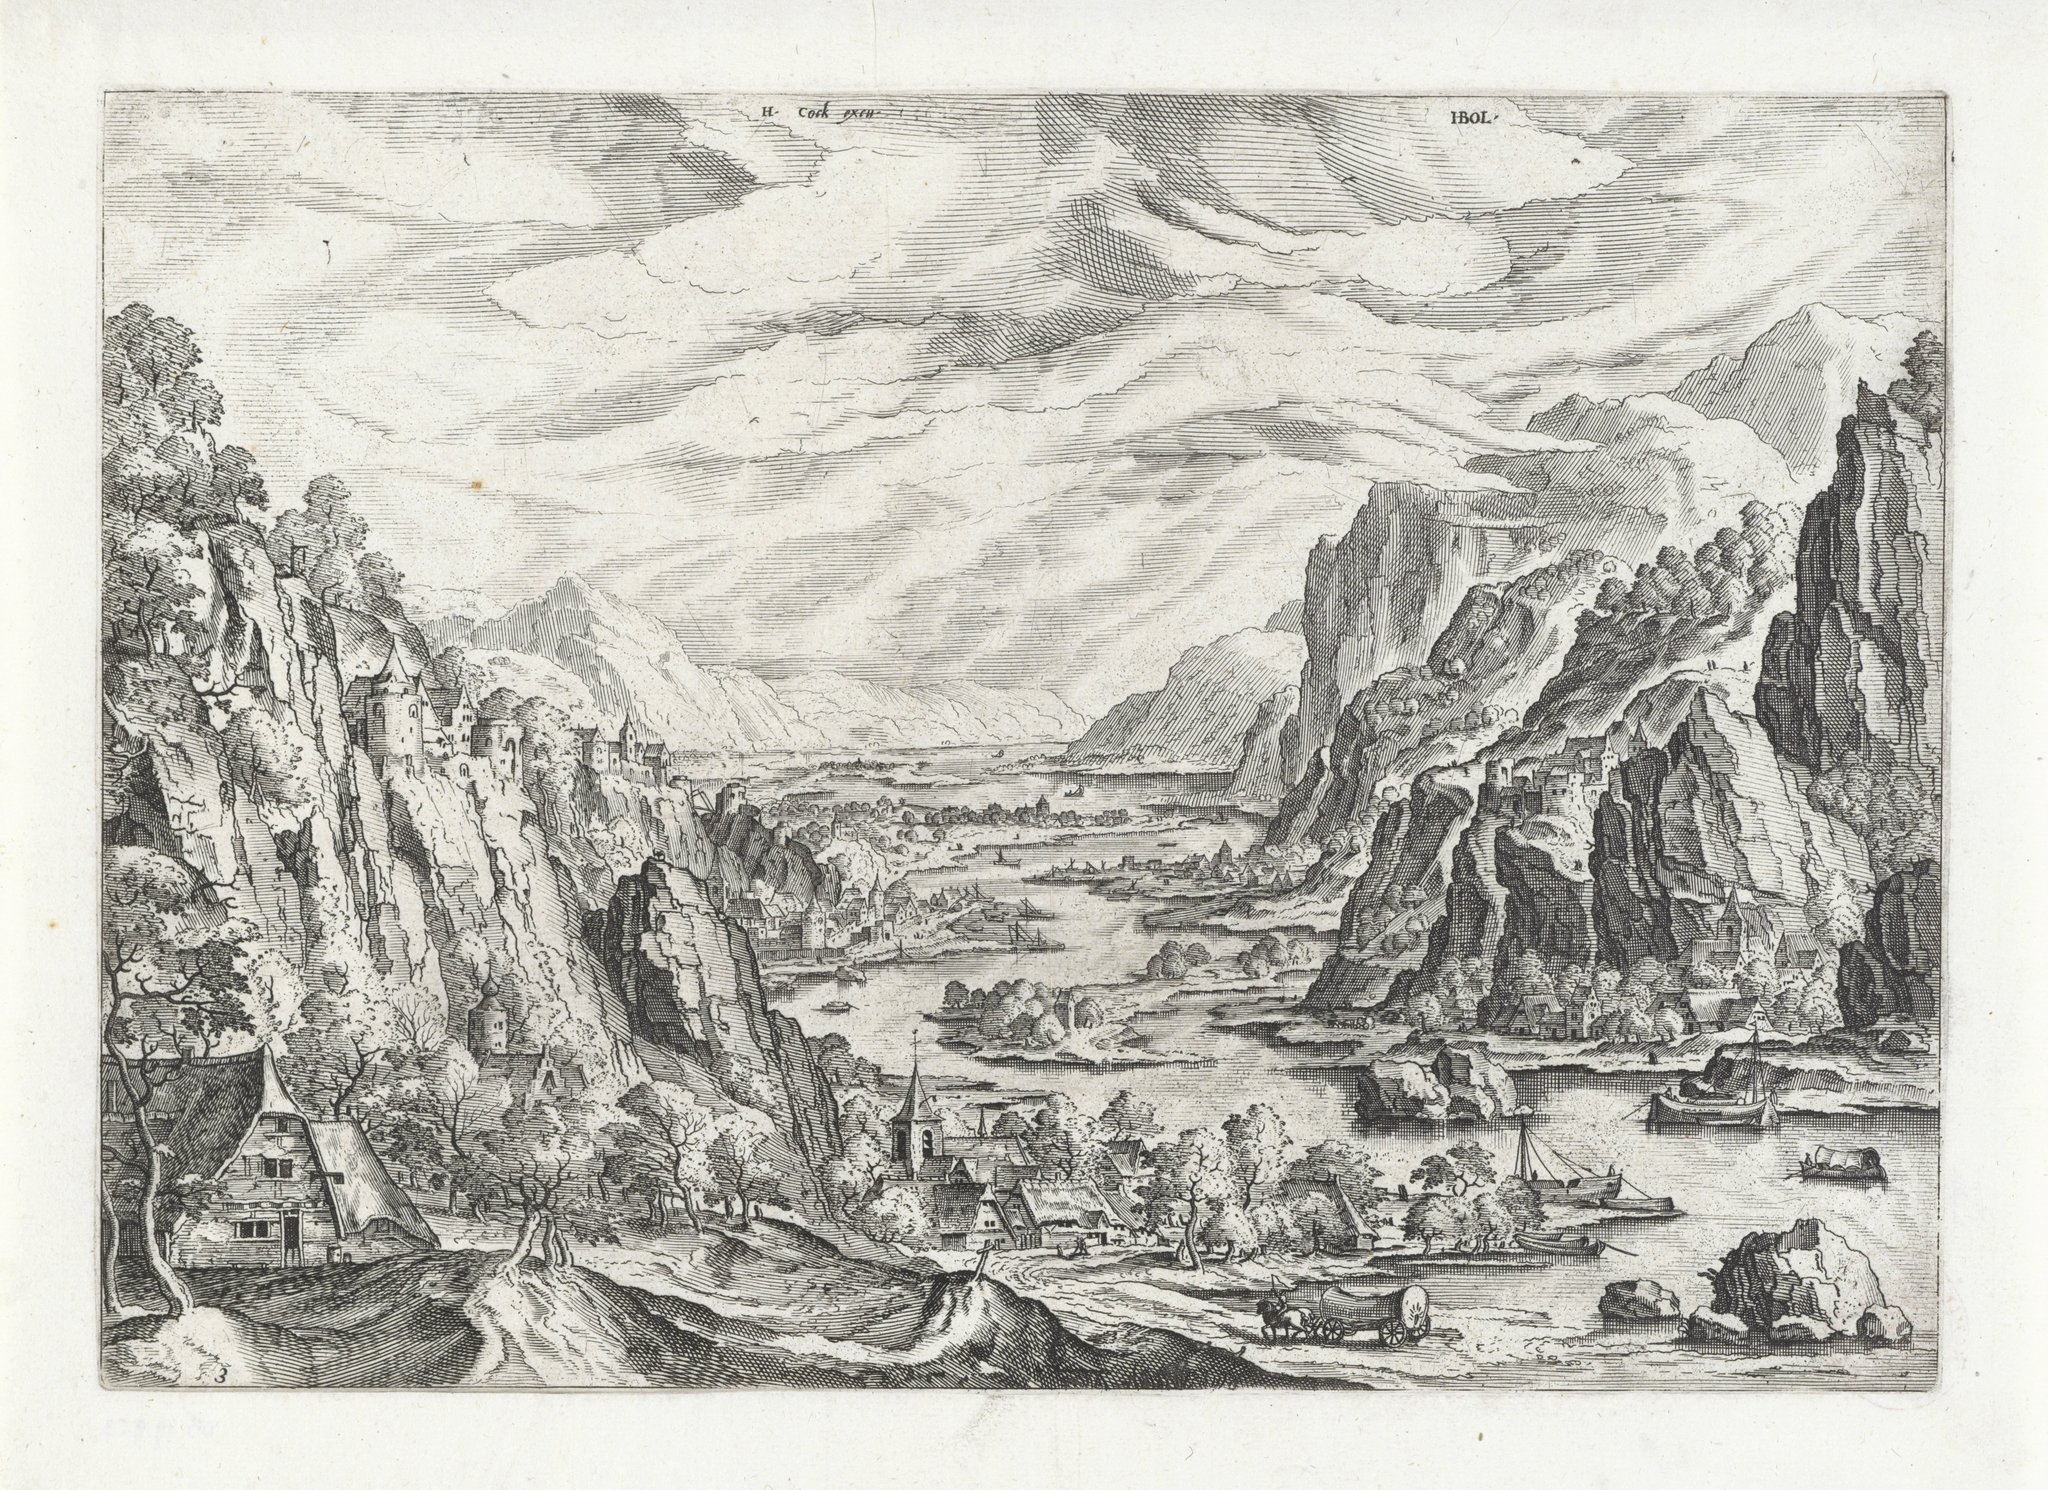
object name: print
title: Rivierlandschap met enkele dorpen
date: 1548-1570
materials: paper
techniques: etching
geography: low countries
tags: village, covered wagon, hooded wagon, rock-formations, river (+ landscape with figures, staffage)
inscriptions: collector's mark: Lugt 240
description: Te midden van hoge rotswanden stroomt een rivier. Op beide rivieroevers liggen enkele dorpen. Linksvoor een boerenhoeve en rechtsvoor trekken twee paarden een gehuifde wagen. Op de rivier liggen enkele boten.